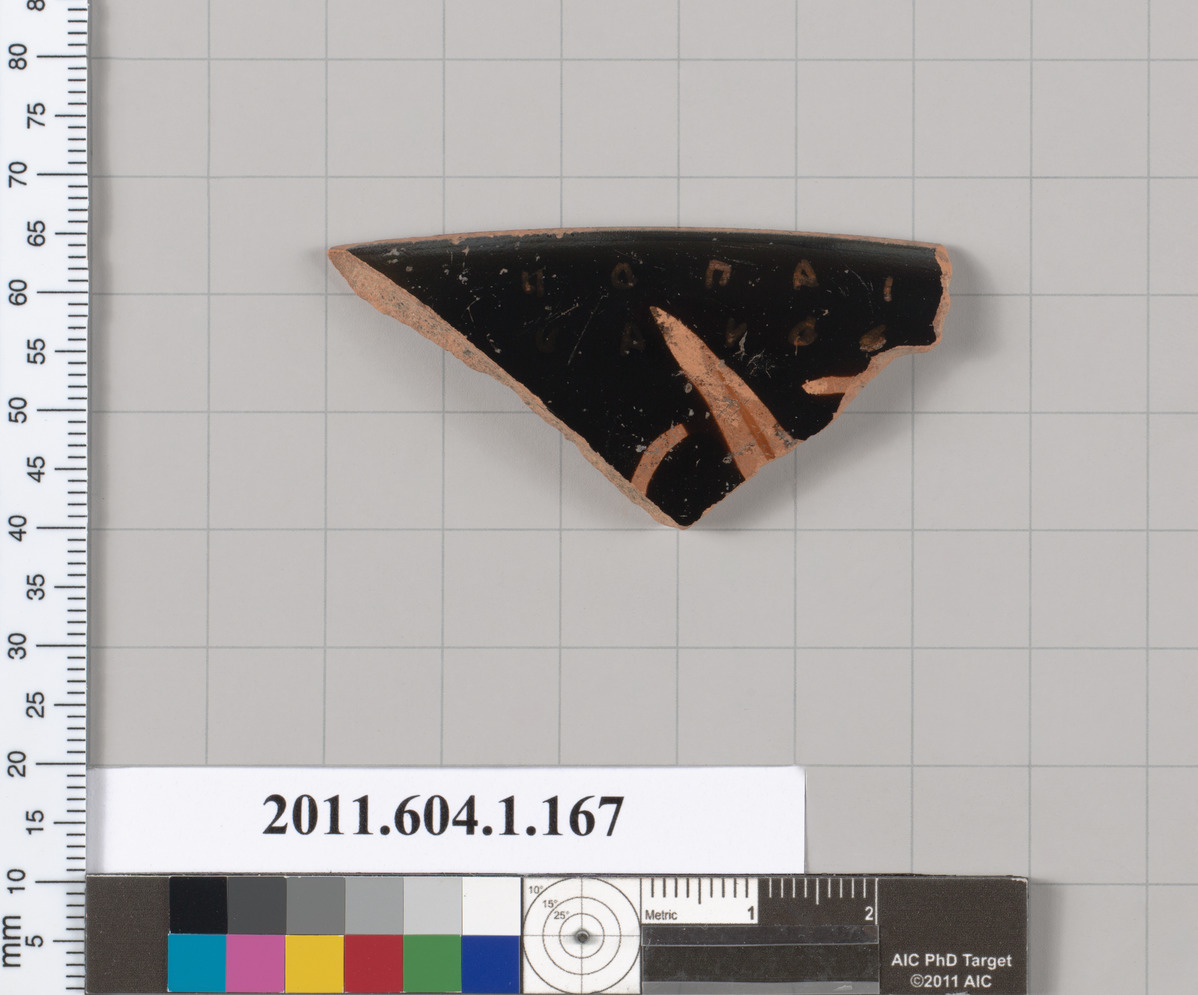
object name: kylix fragment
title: Terracotta fragment of a kylix (drinking cup)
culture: greek, attic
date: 470-450 BCE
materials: terracotta